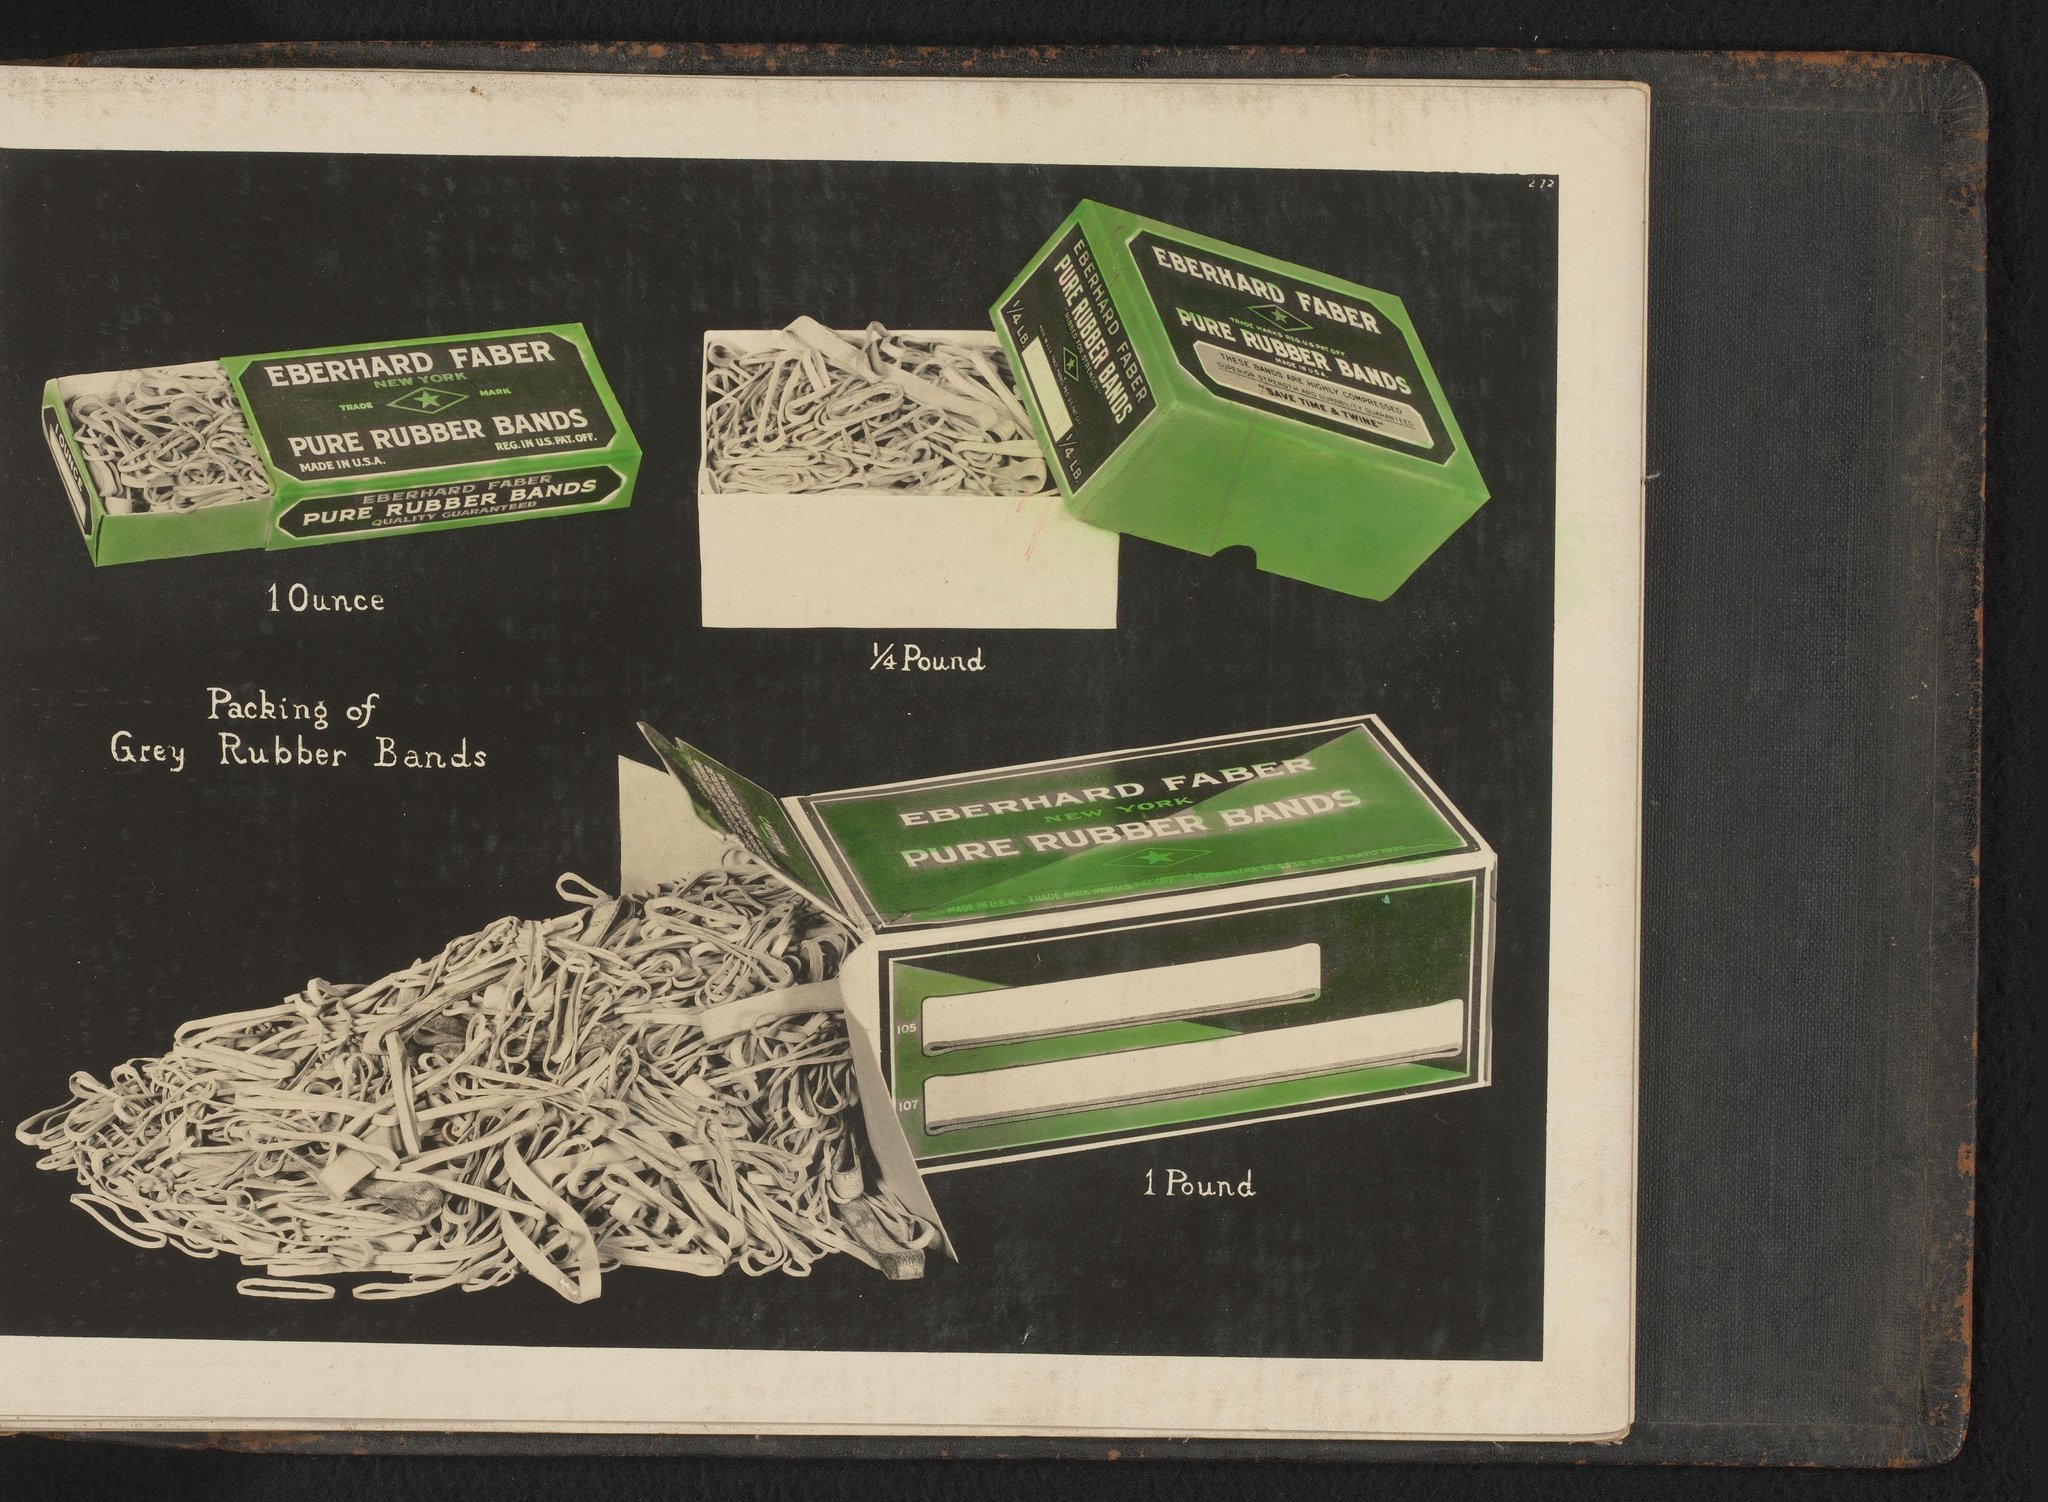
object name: photograph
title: Dozen met elastieken van Eberhard Faber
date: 1915-1935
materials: paper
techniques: gelatin silver print, hand coloring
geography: springfield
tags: writing accessories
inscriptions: stamp: ‘Paramount/ Commercial Studios/ 145 Chestnut St./ Springfield - Mass.’, number: ‘272’